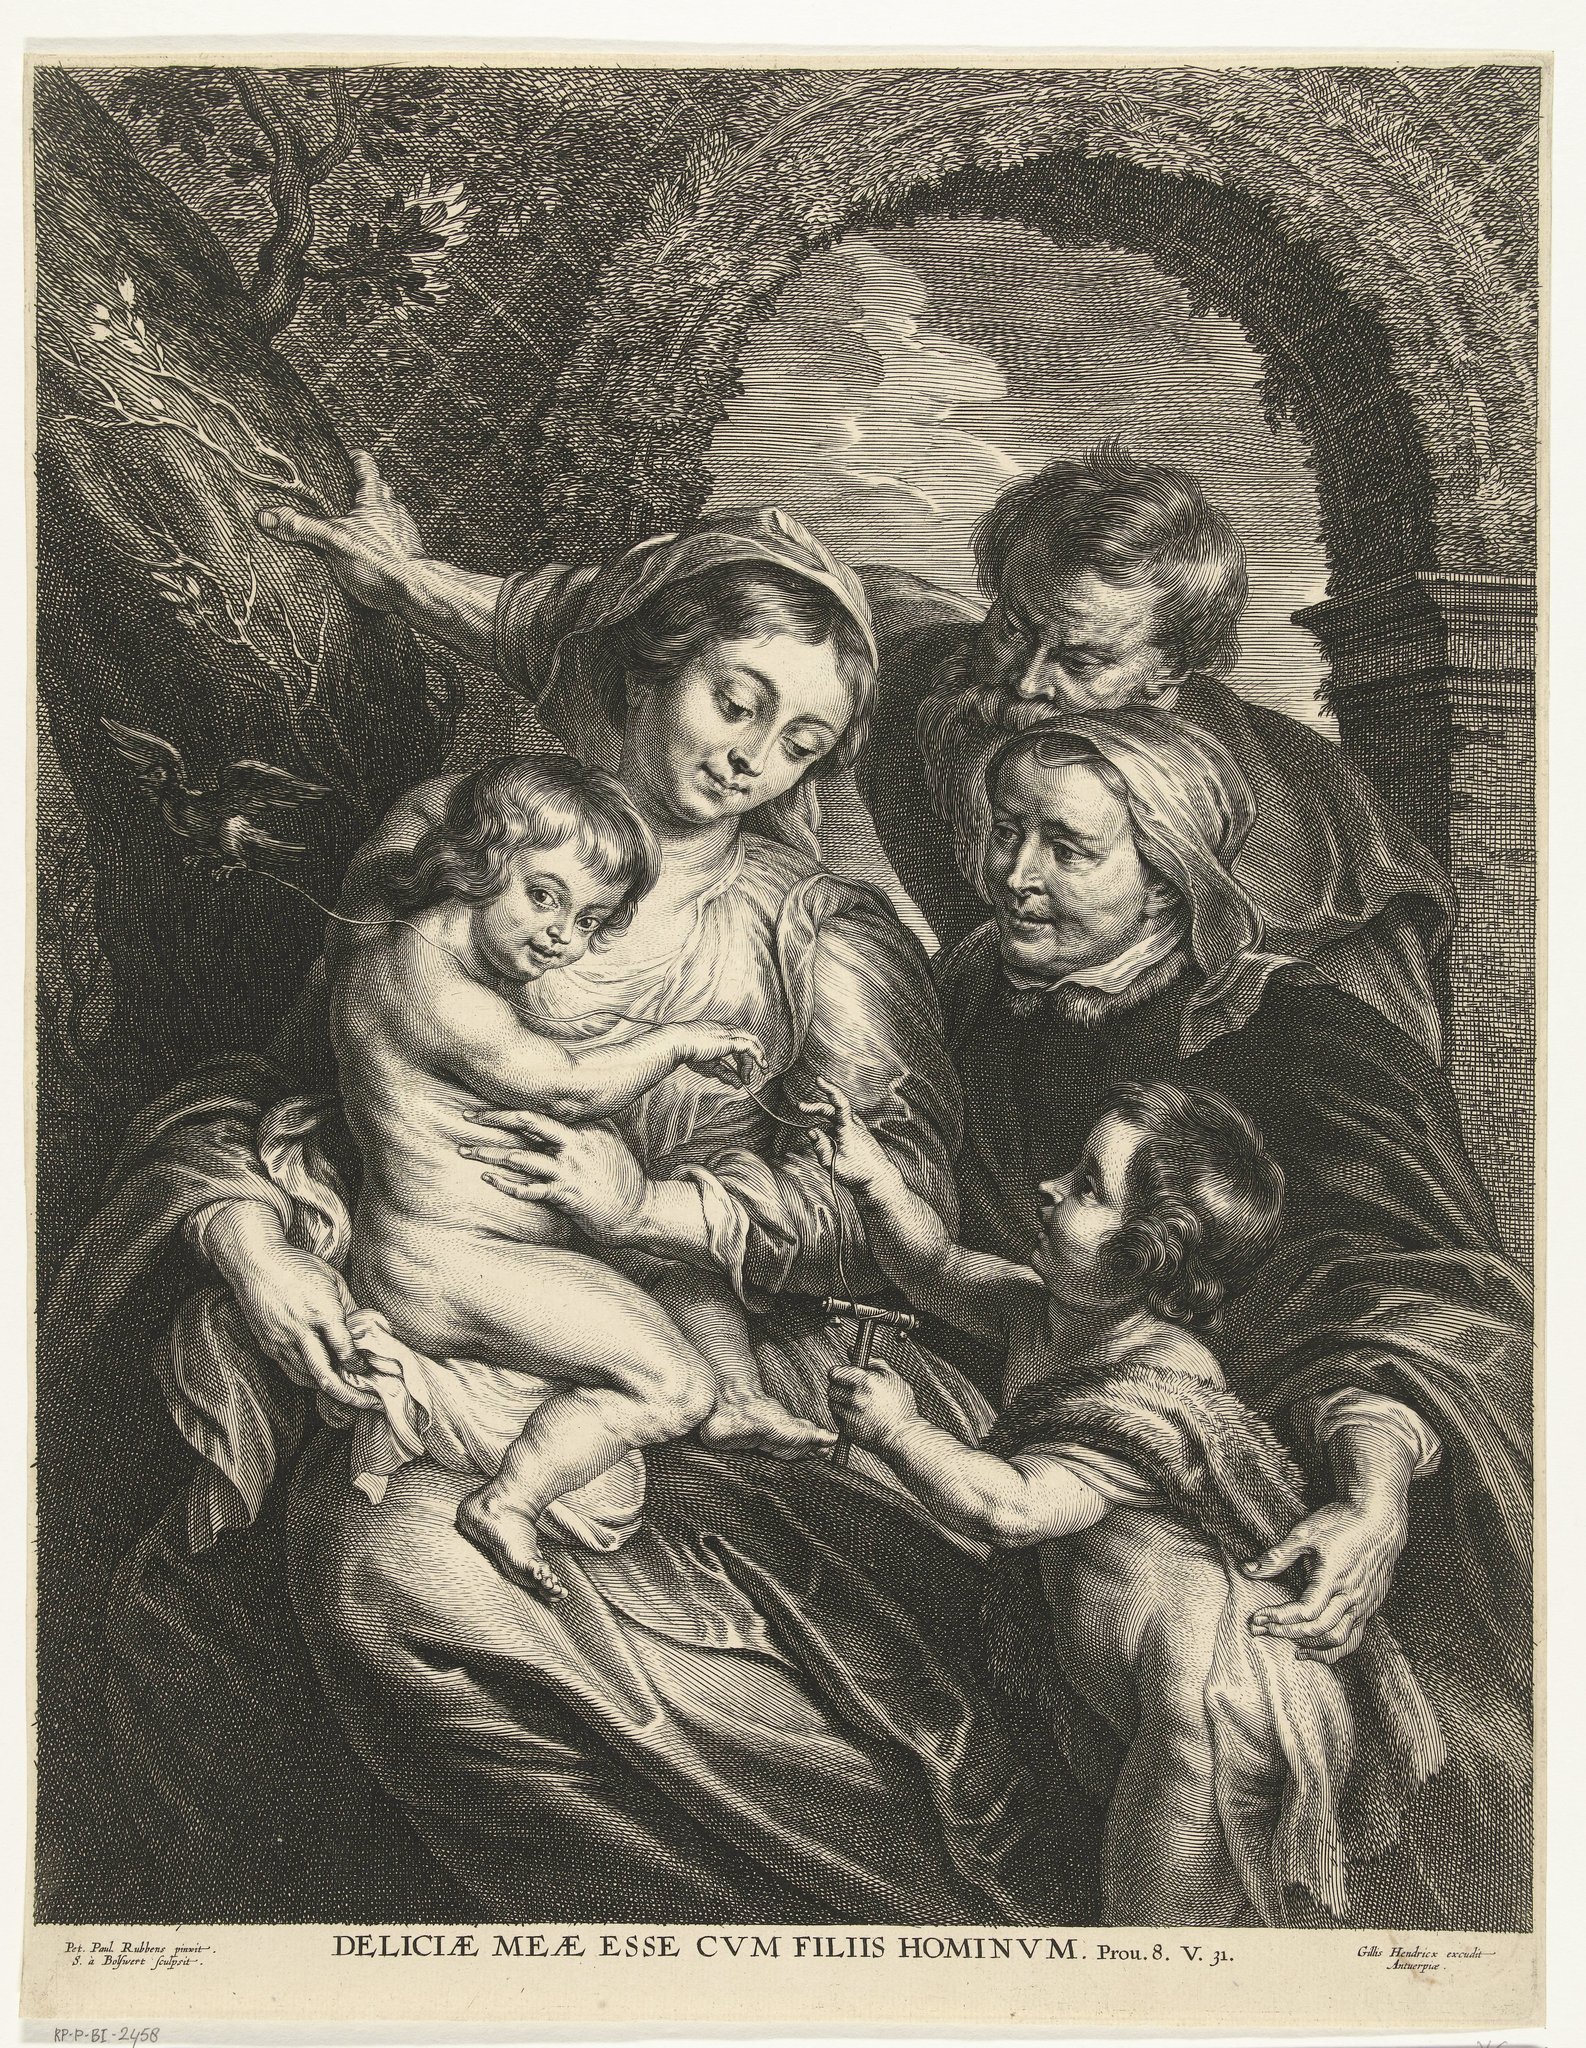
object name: print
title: Heilige familie met distelvink en Anna en Johannes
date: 1596-1659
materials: paper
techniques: engraving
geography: antwerp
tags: holy family, and derived representations, song-birds: goldfinch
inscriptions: collector's mark: Lugt 240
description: Maria zit in een tuin met het Christuskind op haar schoot. De heiligen Jozef, Anna en Johannes als kind staan bij hen. Het Christuskind houdt een distelvink aan een touwtje vast, het vogeltje wordt hem door Johannes met een stokje met belletjes aangereikt. Onder de voorstelling staat een regel uit Spreuken 8, vers 31 in Latijn.